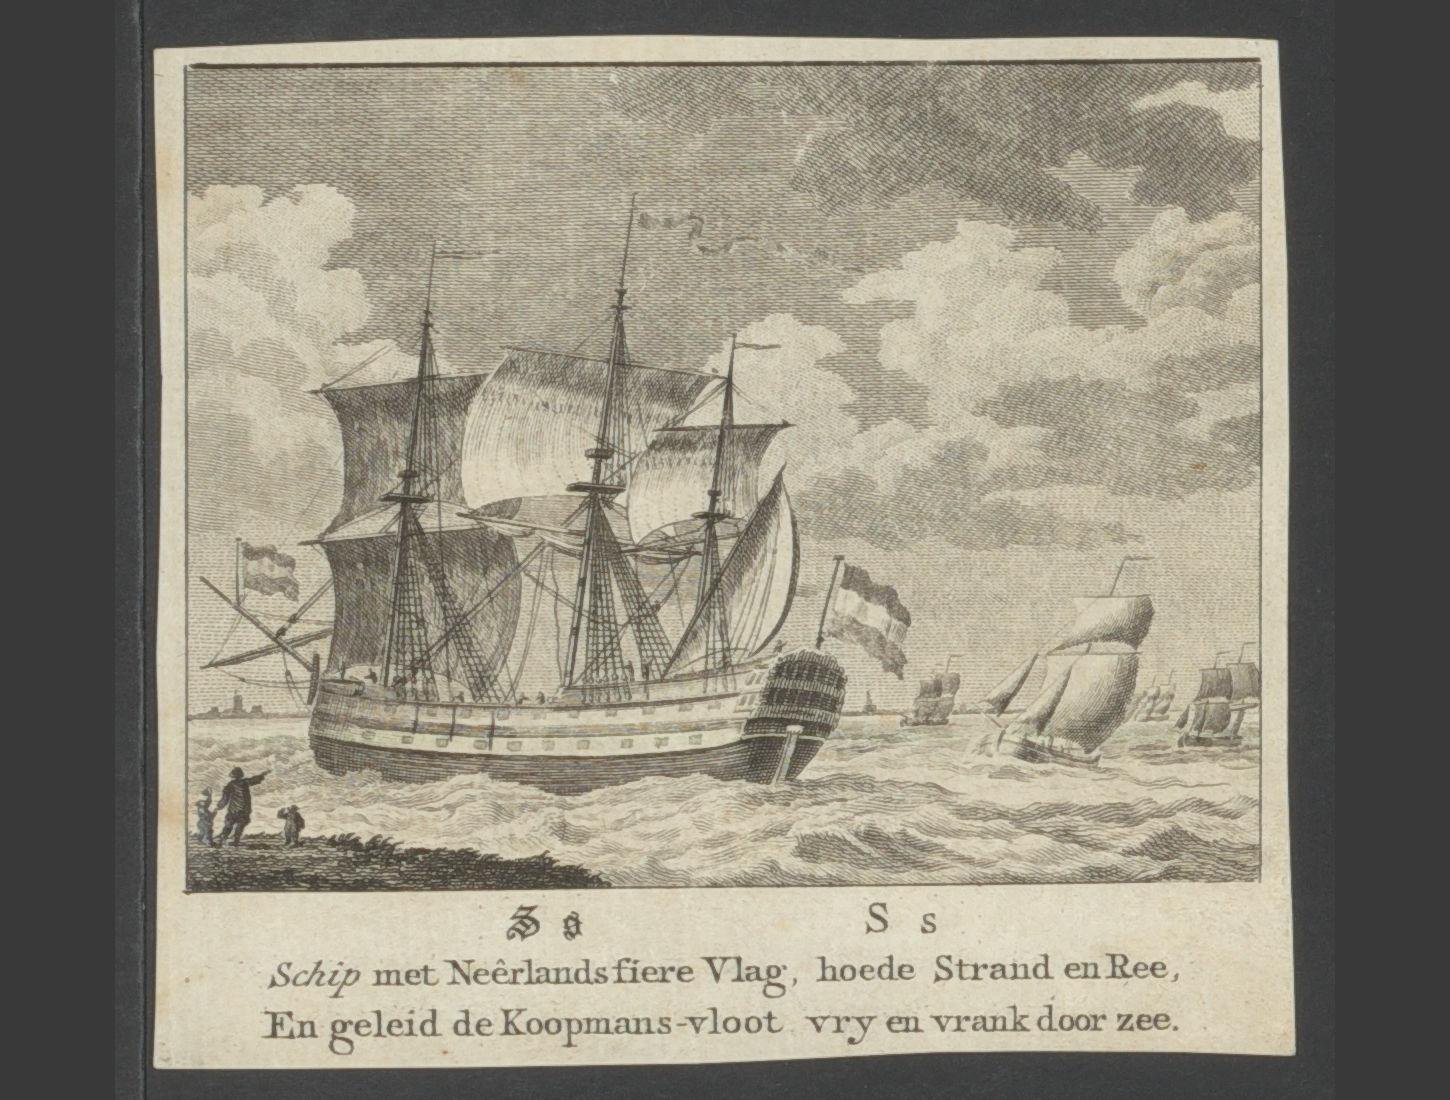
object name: print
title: Schip op zee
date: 1781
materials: paper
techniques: engraving, etching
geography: amsterdam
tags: sailing-ship, sailing-boat, letters, alphabet, script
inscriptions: collector's mark: Lugt 1641, stamp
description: Onder de voorstelling de letter S in twee verschillende lettertypes. Onderaan een tweeregelig vers over schepen. Onderwerpsrubrieken binnen de Atlas Zeden en Gewoonten: Onderwijs en Wetenschappen, Opvoeding en Onderwijs, Haneboeken en schoolprenten.